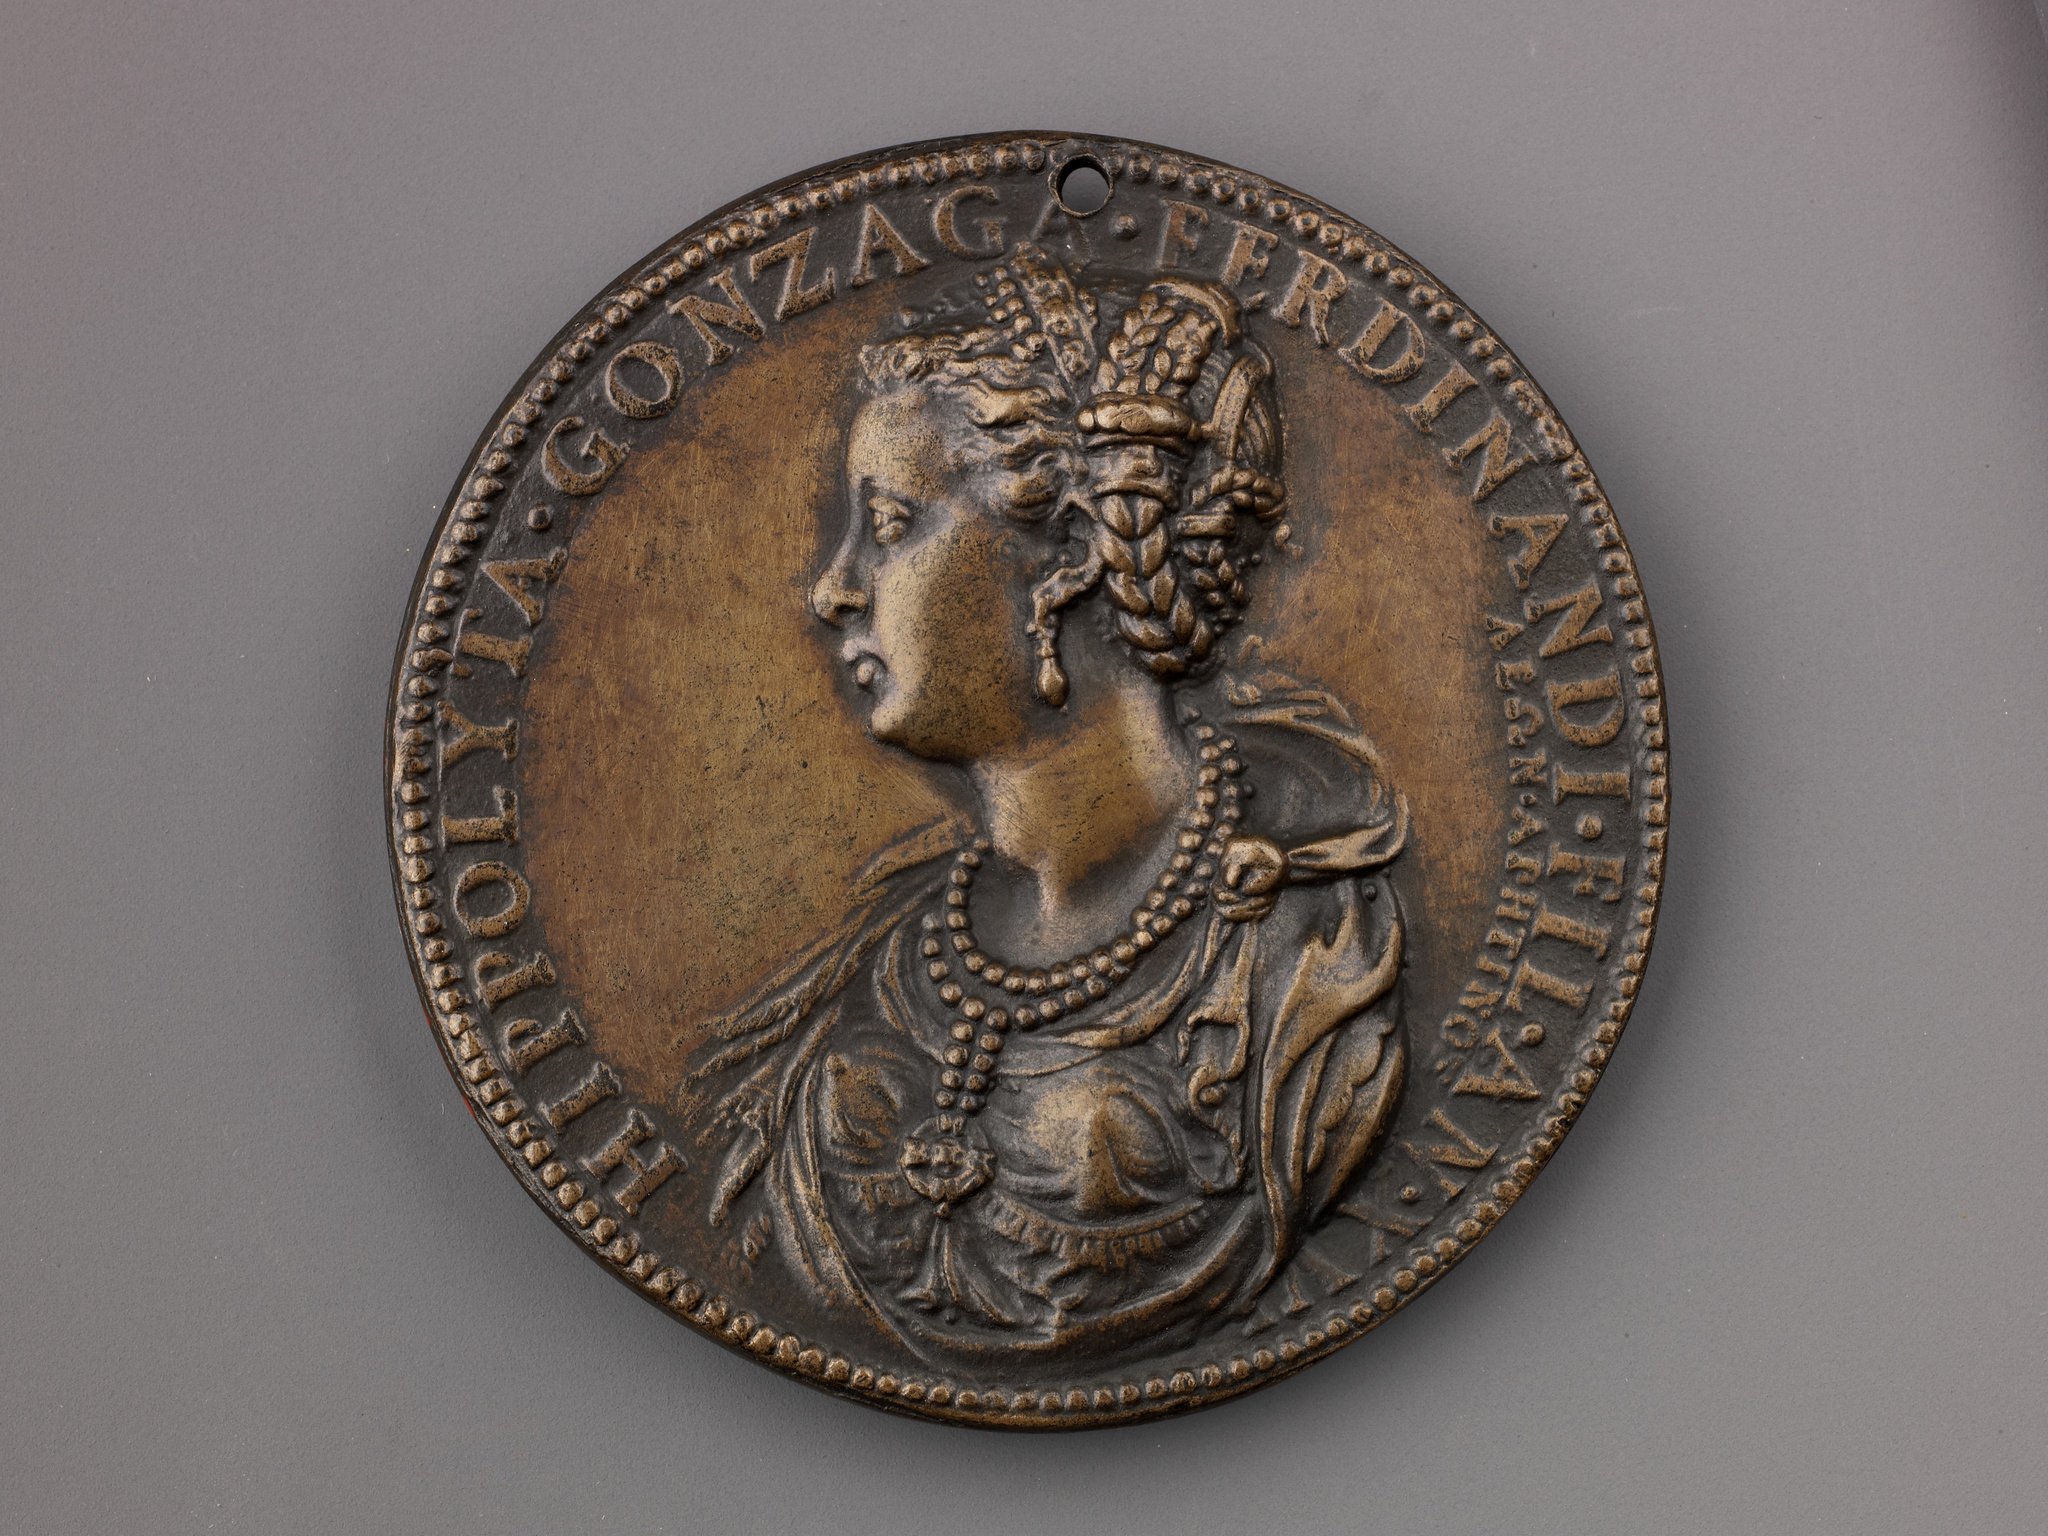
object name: medal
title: Medal: Ippolita Gonzaga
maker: leone leoni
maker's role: artist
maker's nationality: italian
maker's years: 1504-1590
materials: bronze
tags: portraits,profiles,women